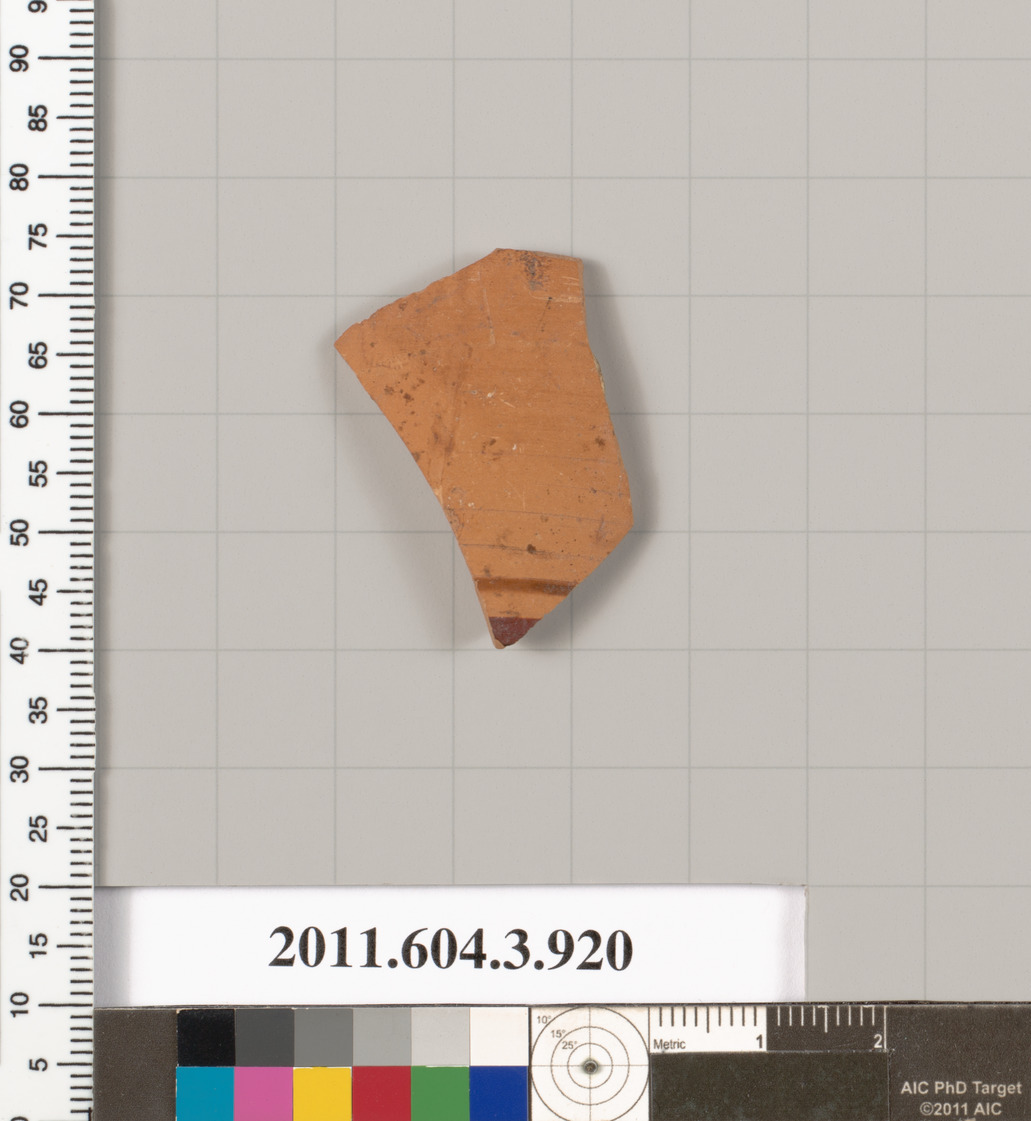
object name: lekythos fragment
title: Terracotta fragment of a lekythos (oil flask)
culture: greek, attic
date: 600-401 BCE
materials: terracotta